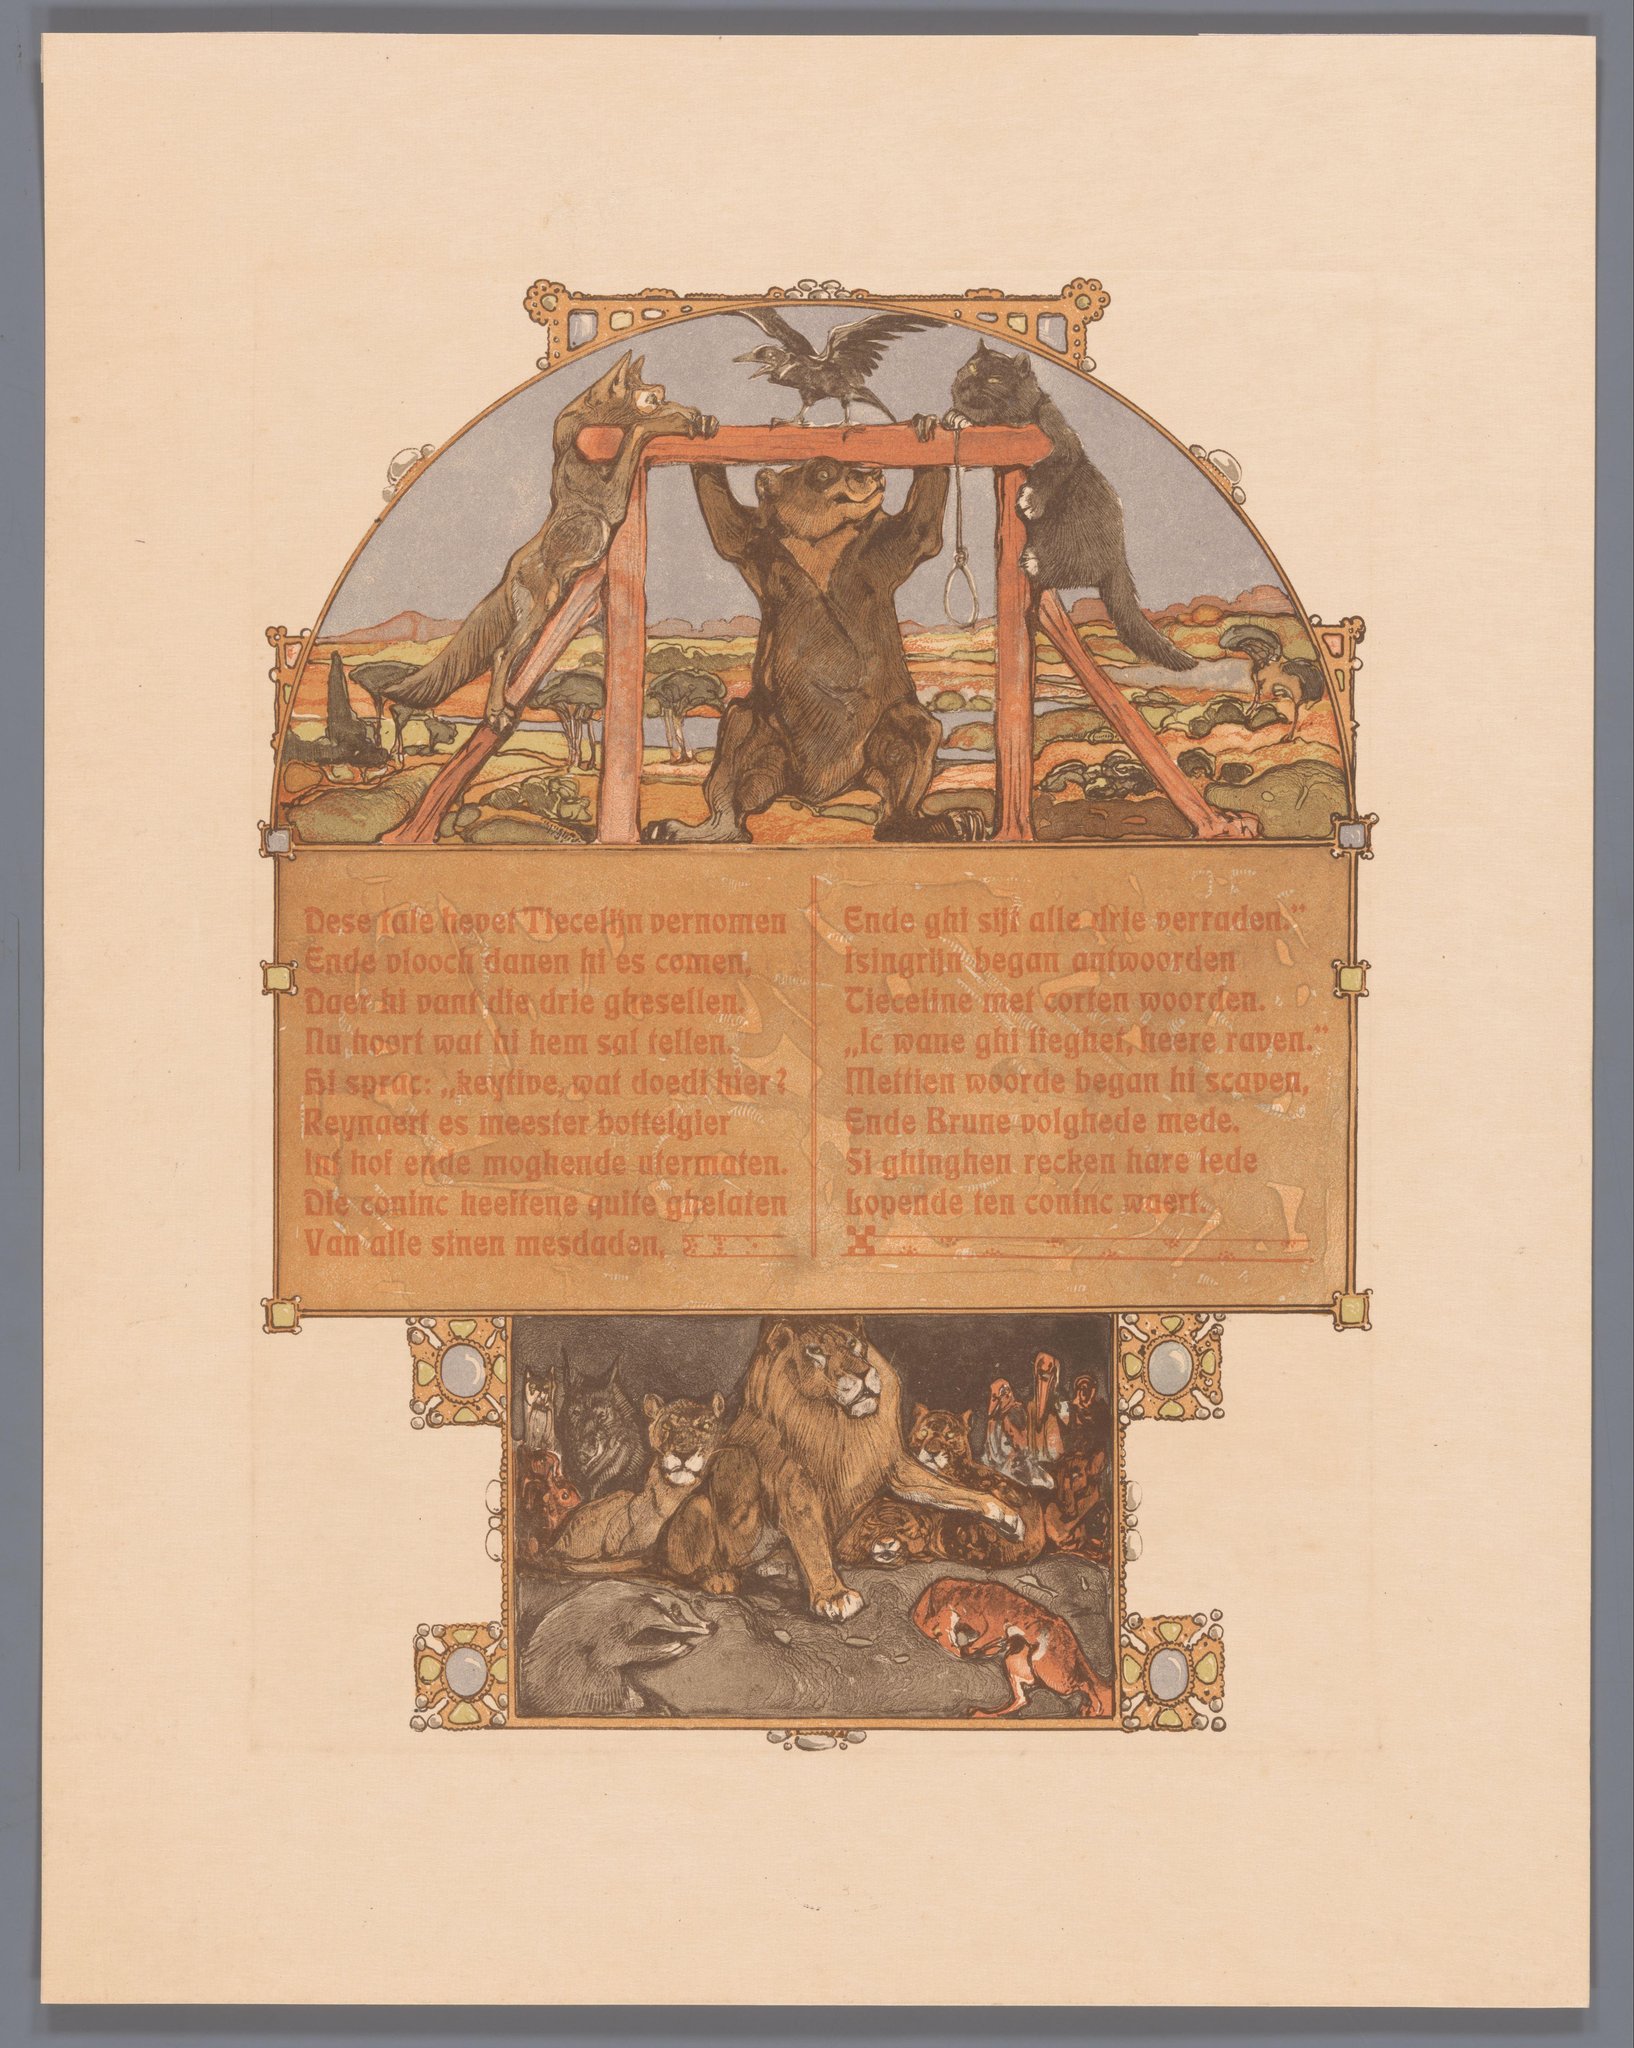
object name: book illustration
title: Vos (Reinaert), beer (Bruun), kat (Tybeert) en raaf (Tiecelijn) bij galg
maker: bernard willem wierink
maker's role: draughtsman, print maker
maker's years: 1856-1939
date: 1910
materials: paper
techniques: lithograph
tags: fable of reynard the fox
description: Prent gebruikt in: Streuvels, Stijn (Frank Lateur). Reinaert de Vos naar verschillende uitgaven van het middeleeuwsche epos. Amsterdam: L.J. Veen, 1910.